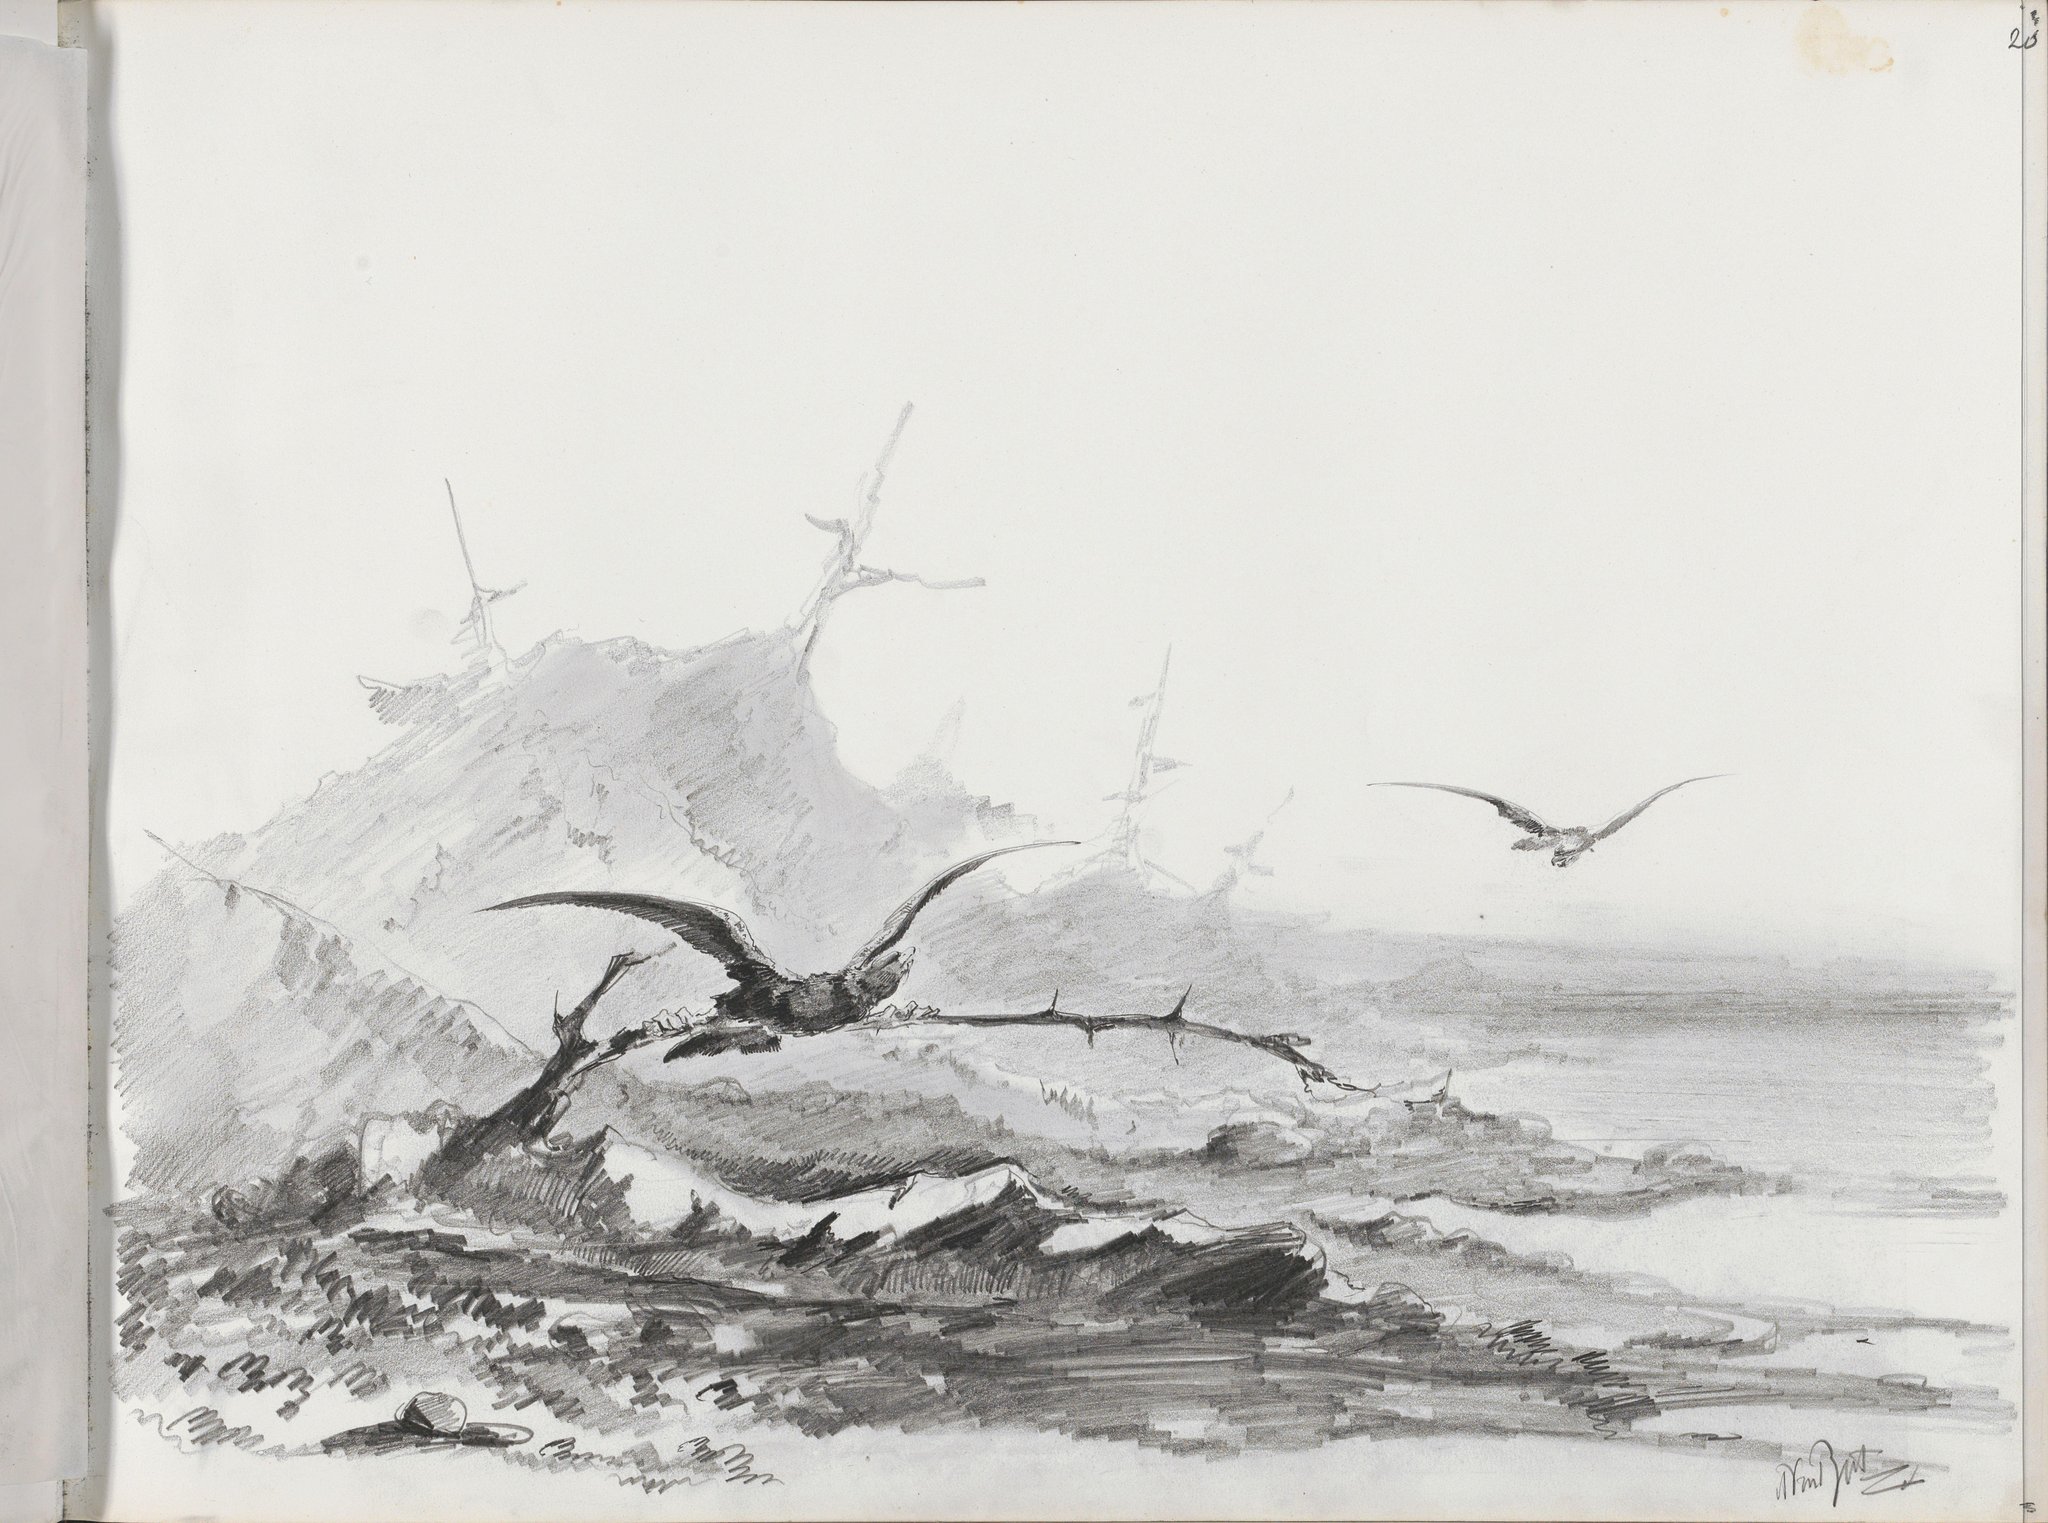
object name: sketchbook leaf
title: Zeemeeuwen bij een rotskust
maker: albertus van beest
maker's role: draughtsman, print maker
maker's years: 1820-1860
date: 1830-1860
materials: paper, pencil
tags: rocky coast, shore-birds and wading-birds: gull, parts of ship's exterior: mast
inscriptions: signature: ‘AVanBeest’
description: Op de achtergrond scheepsmasten. Blad 20 recto uit een schetsboek met 46 bladen.